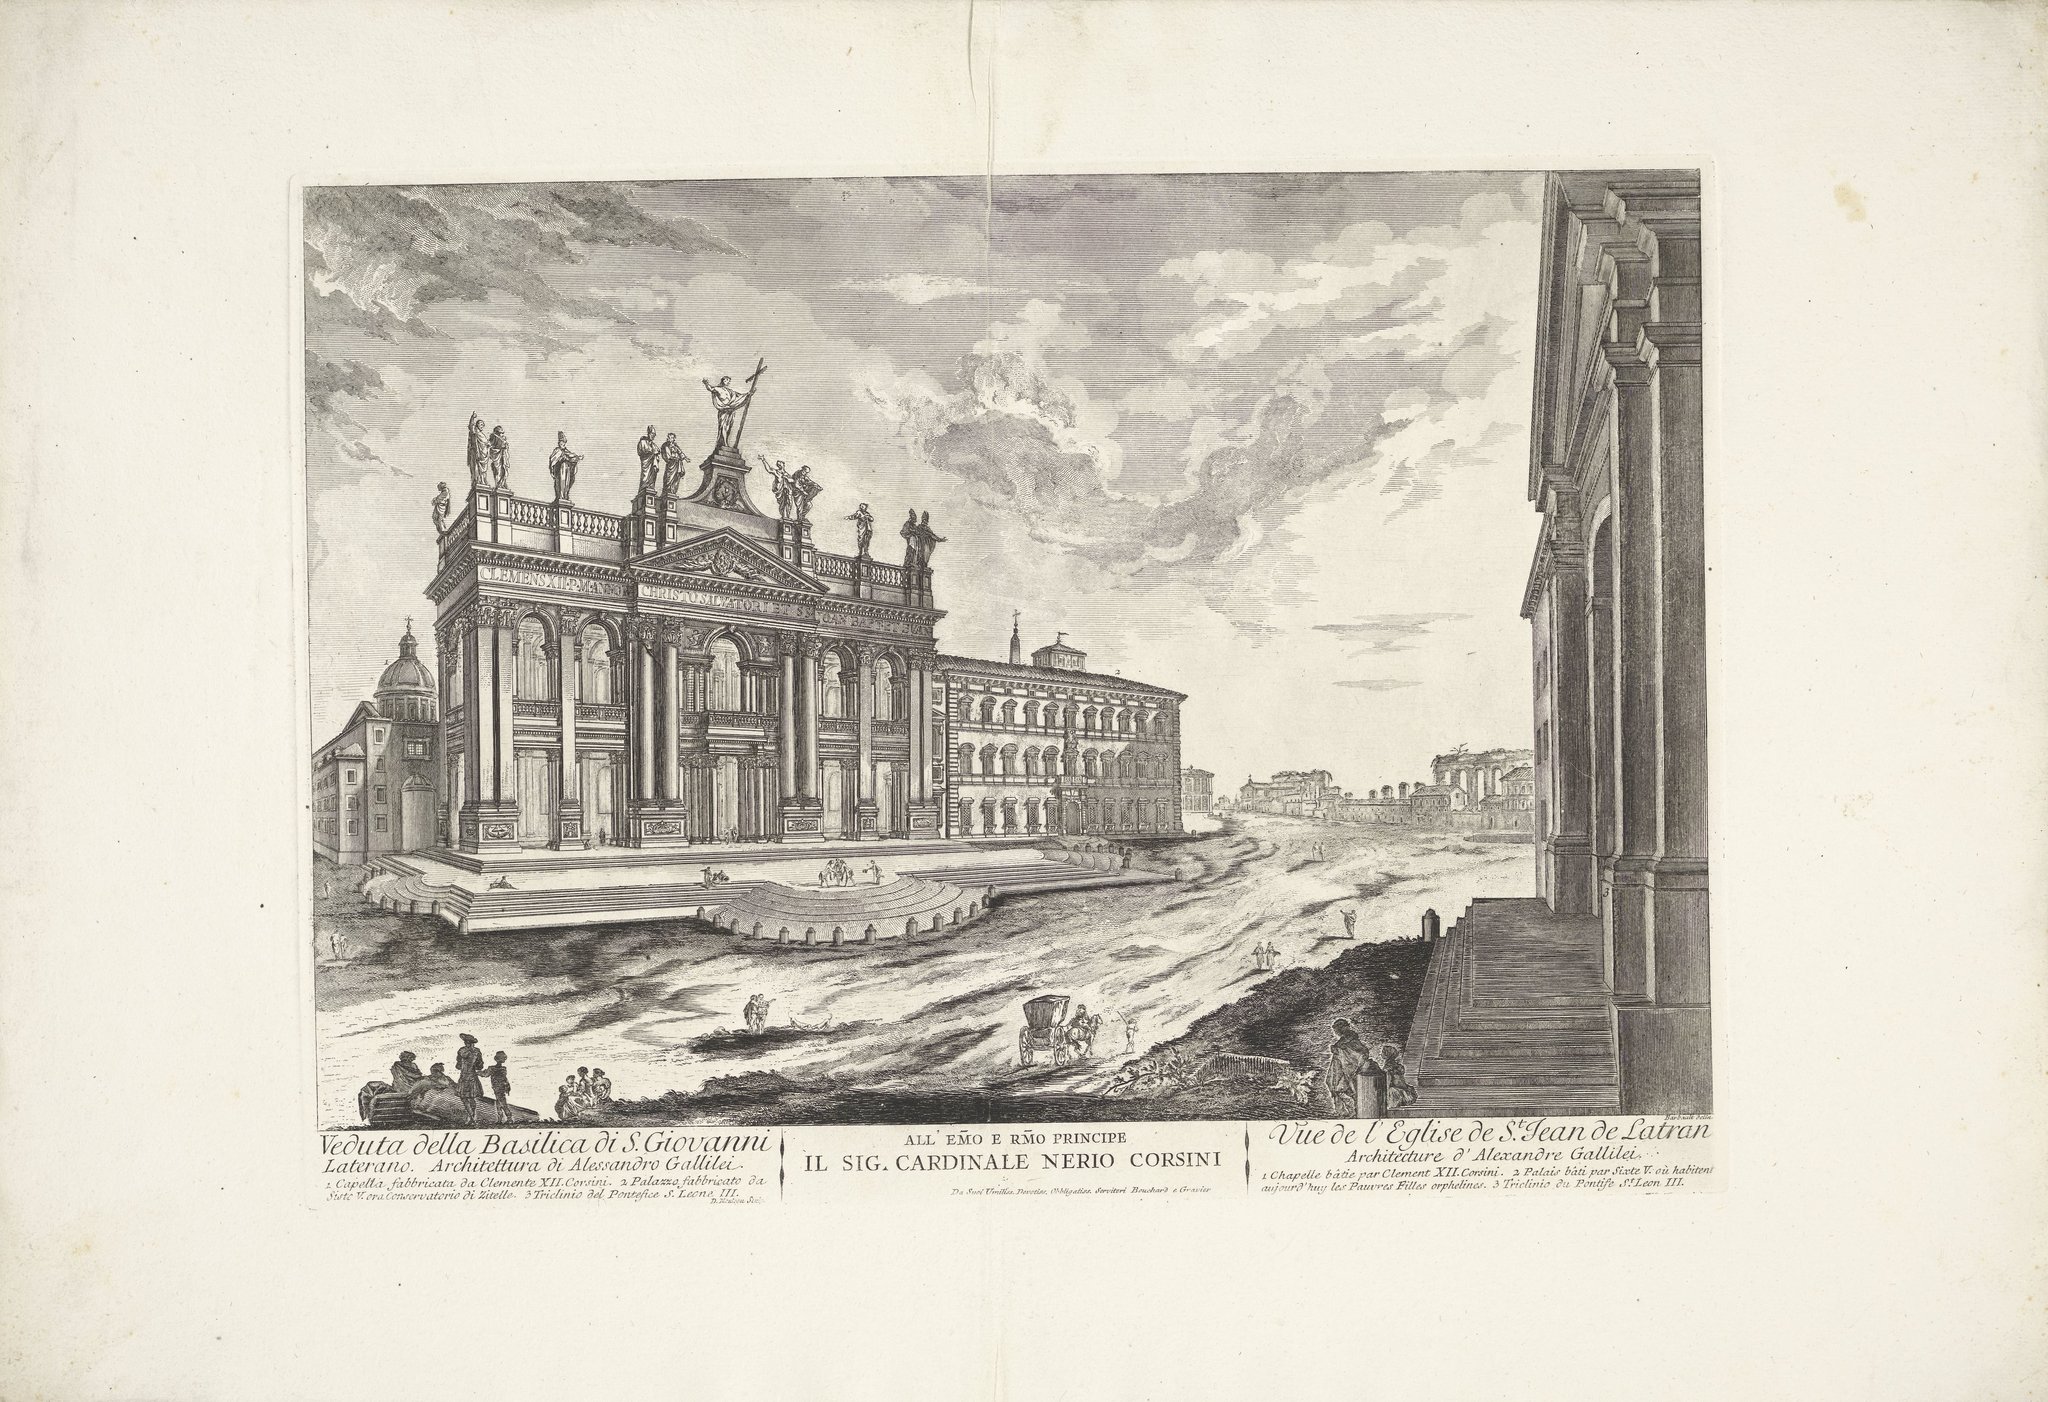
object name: print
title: Veduta della Piazza di S. Giovanni Laterano / Vue de l'Eglise de St. Jean de Latran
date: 1750-1799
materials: paper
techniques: etching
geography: italy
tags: city-view, and landscape with man-made constructions, church (exterior), rome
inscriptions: collector's mark: Lugt 2228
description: Gezicht op de basiliek van Sint-Jan van Lateranen te Rome. Titels en verklarende lijsten met nummers in het Frans en Italiaans en een opdracht in de ondermarge.